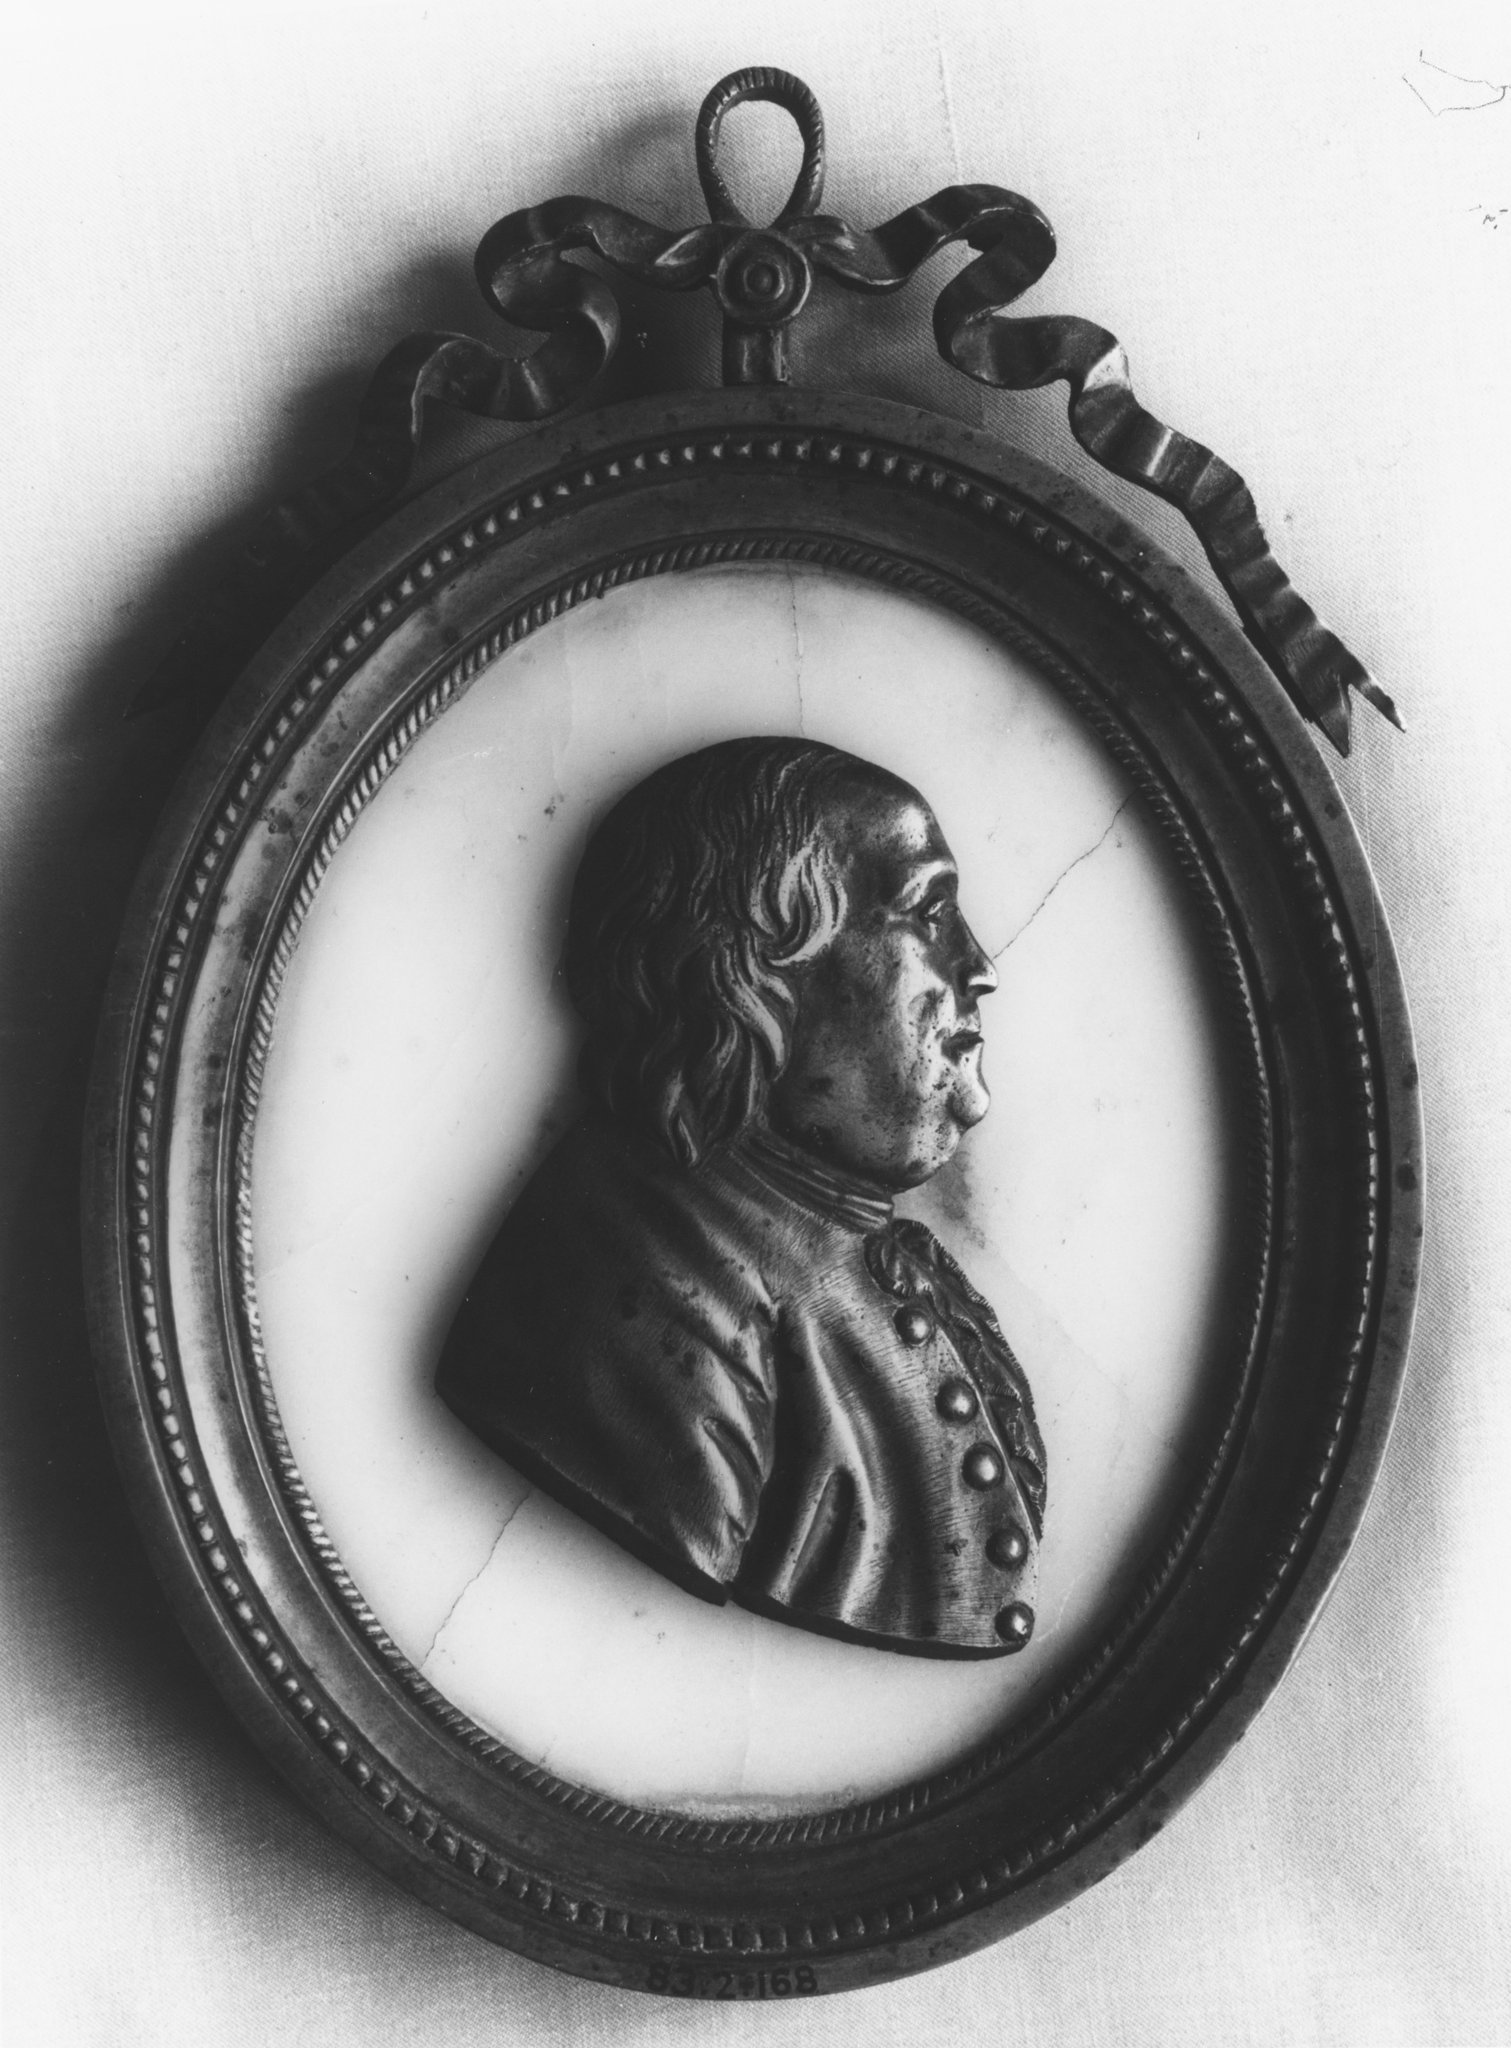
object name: plaque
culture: american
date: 1800-1883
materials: brass, marble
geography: united states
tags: men,profiles